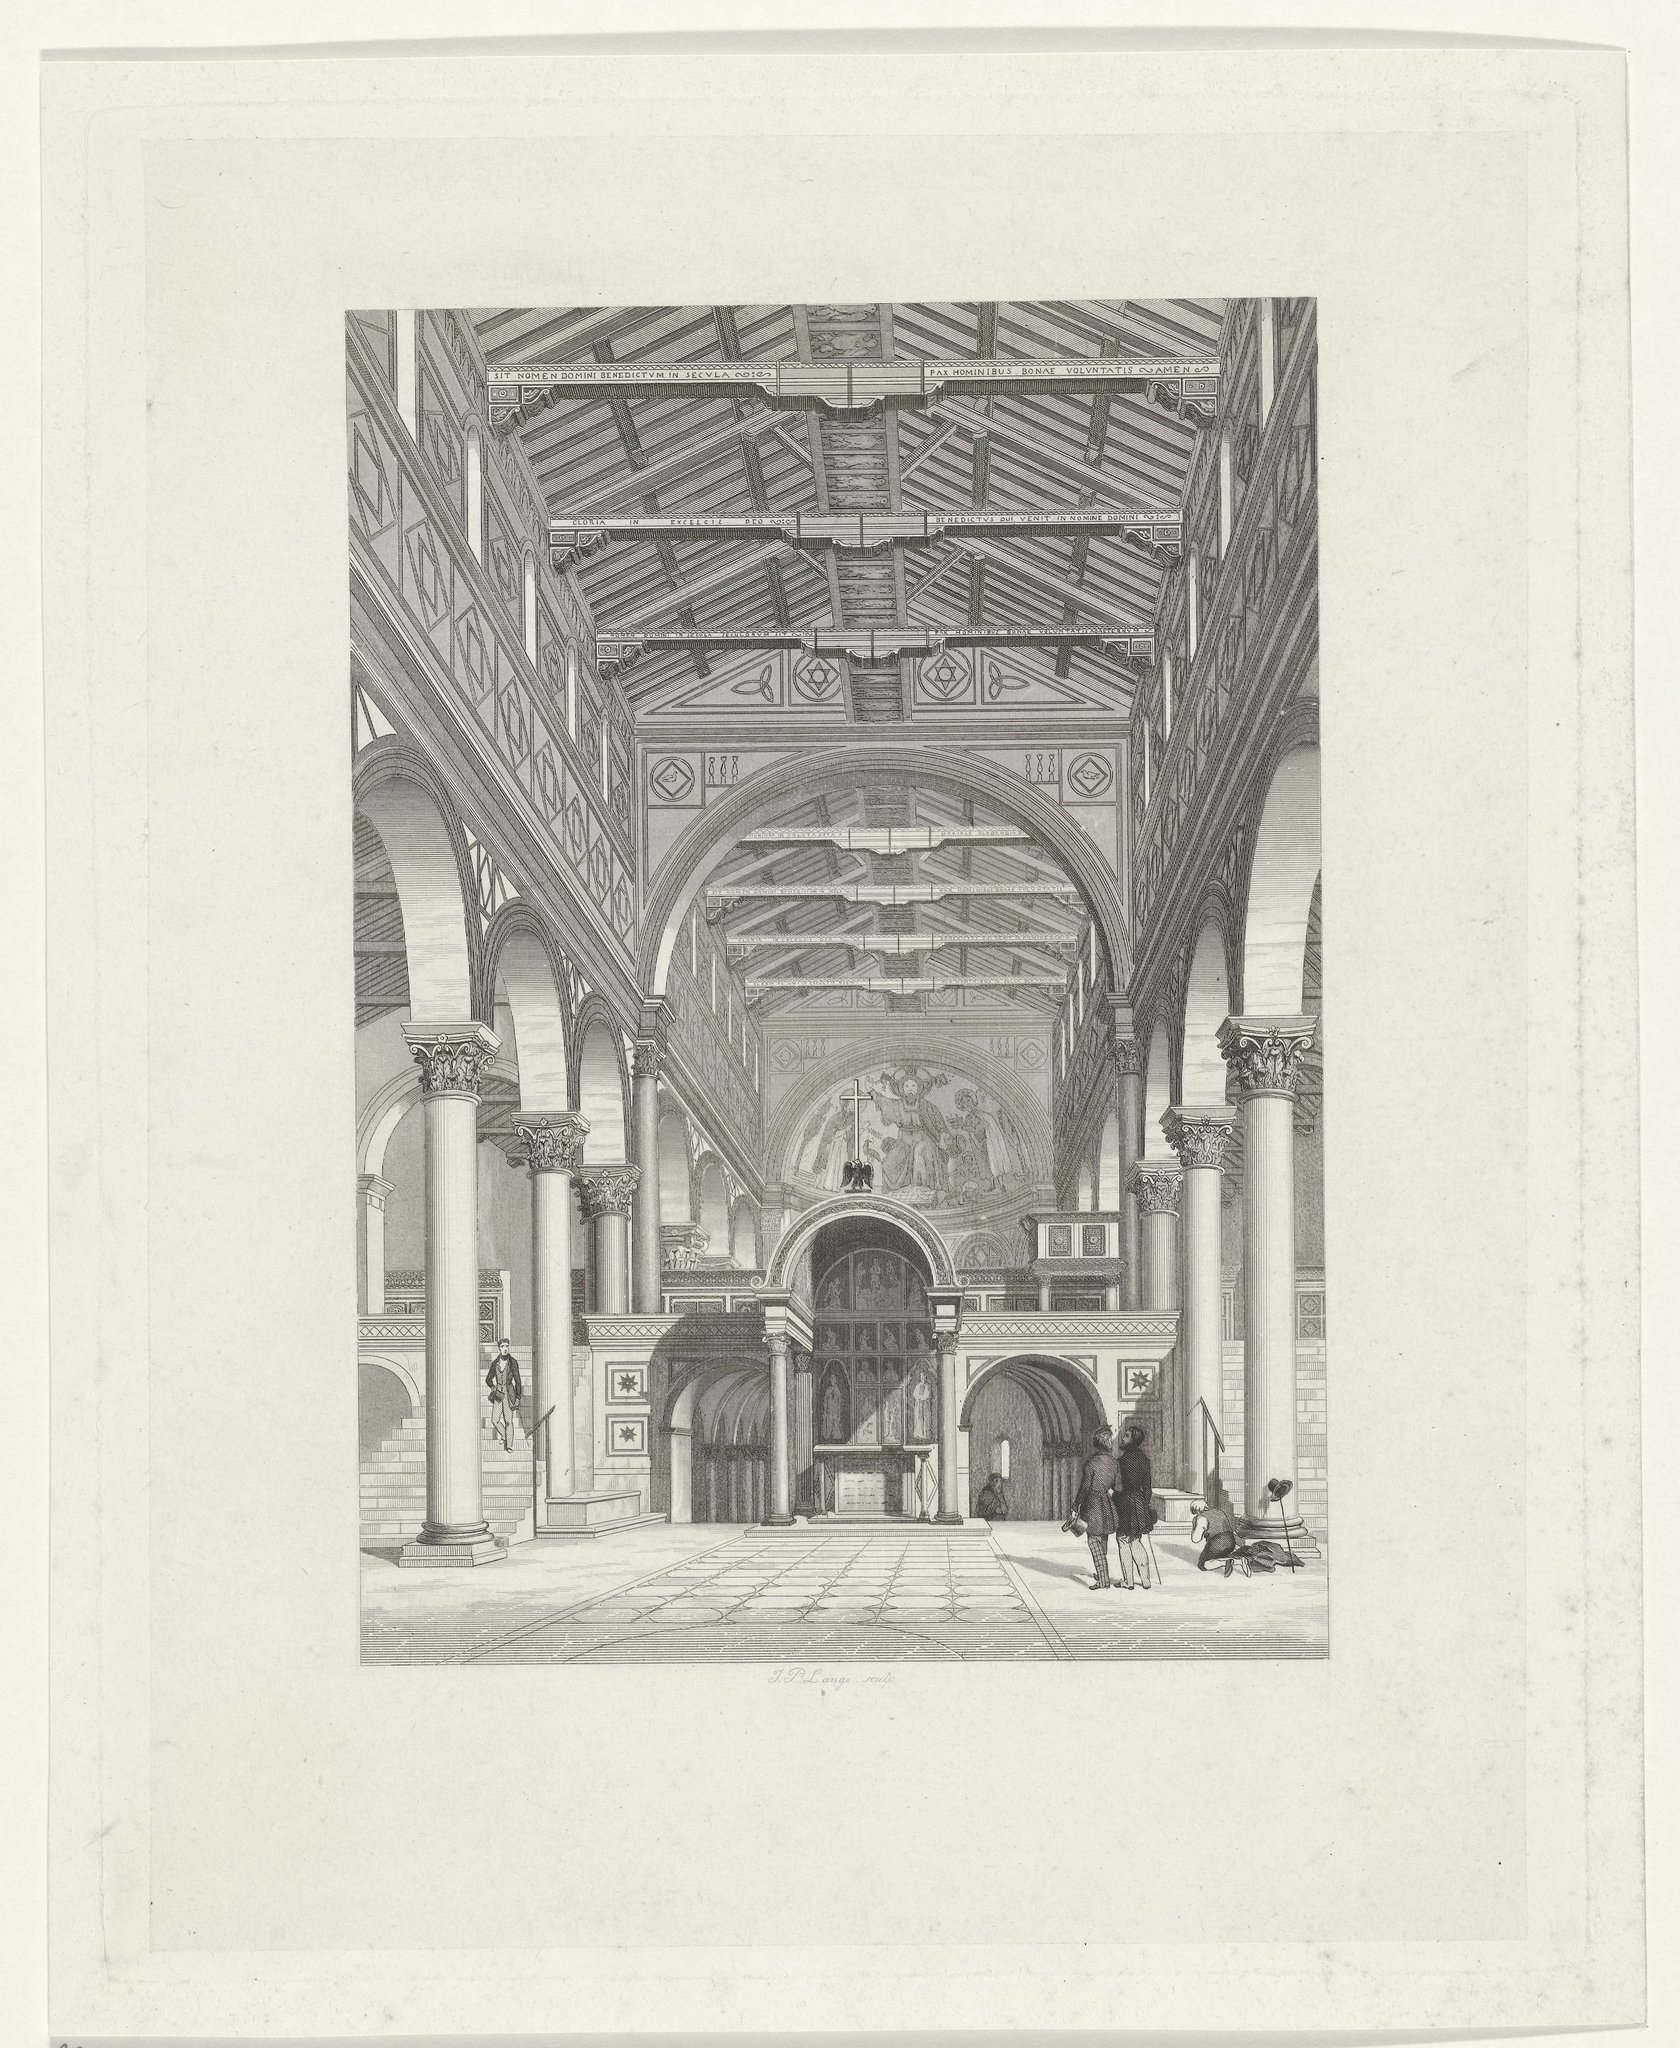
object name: print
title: Kerkinterieur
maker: johannes philippus lange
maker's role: print maker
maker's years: 1810-1849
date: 1820-1849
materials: paper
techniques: engraving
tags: interior of church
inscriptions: collector's mark: Lugt 2228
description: Gezicht op het interieur van een kerk. Rechts staan twee heren, naast hen zit een genielde man te bidden.